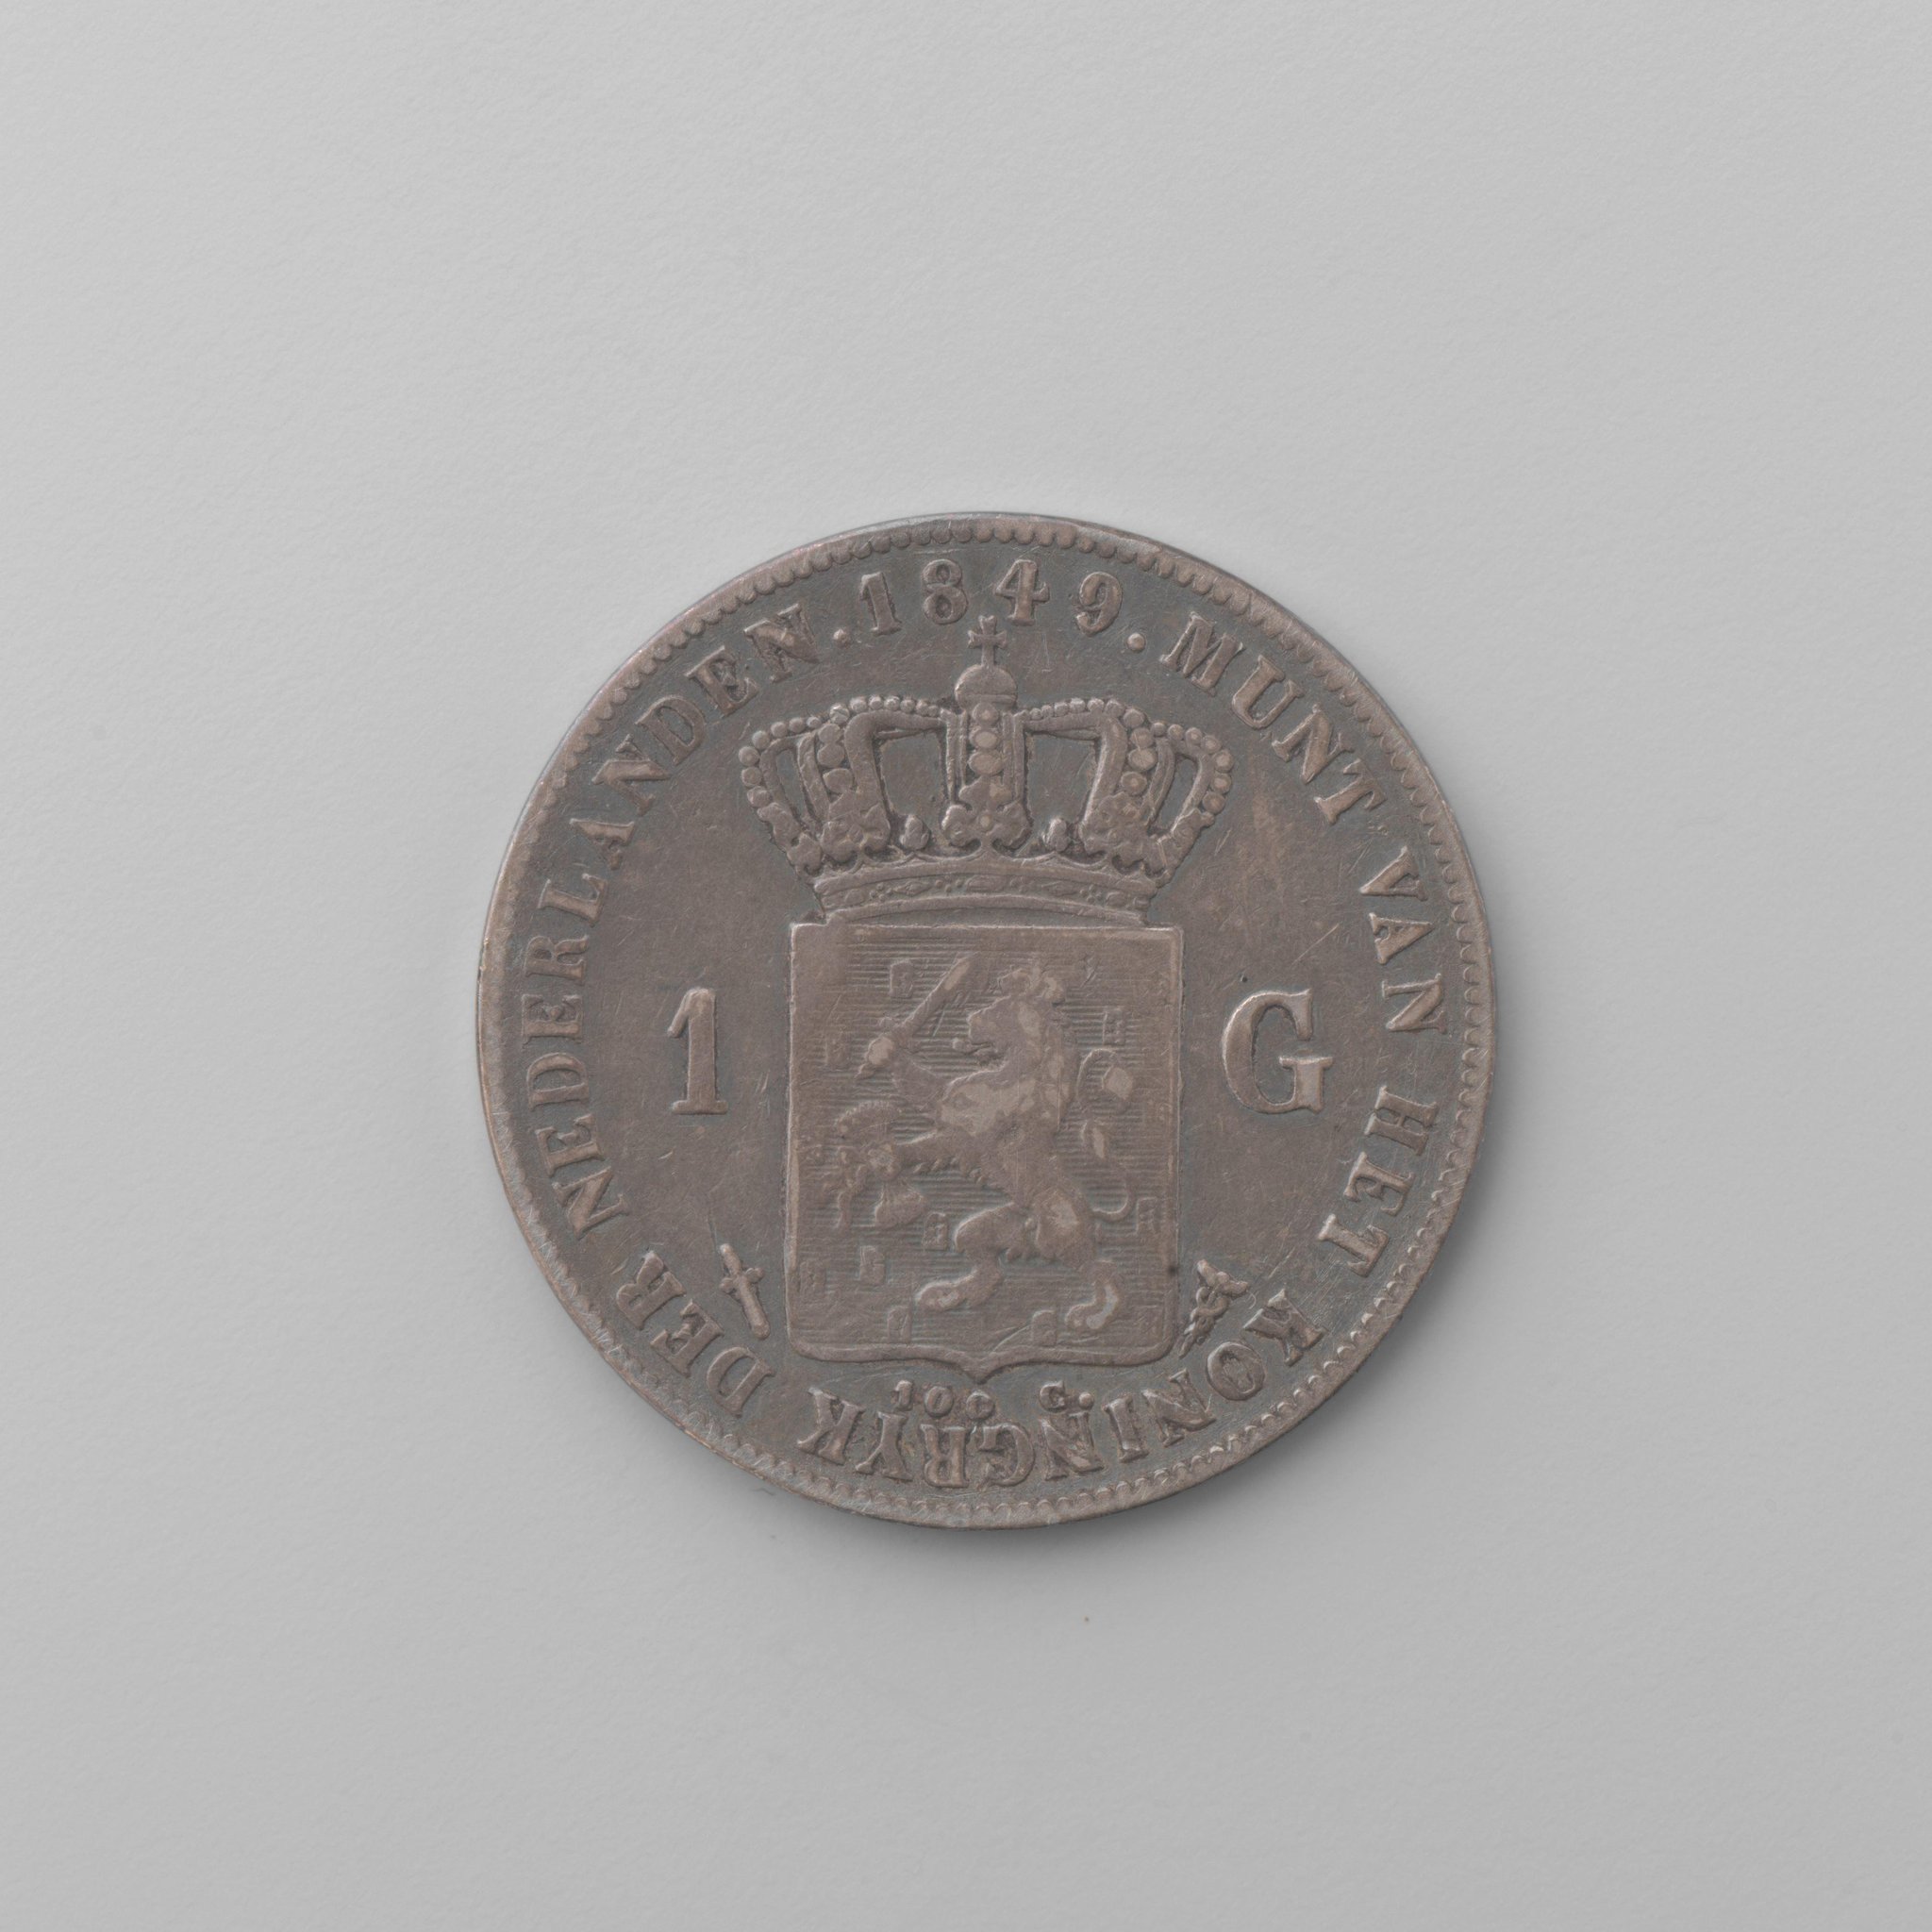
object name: coin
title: Nederland, gulden, 1849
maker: william ii of the netherlands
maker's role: koning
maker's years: 1792-1849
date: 1849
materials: silver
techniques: striking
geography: utrecht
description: Zilveren munt. Voorzijde: borstbeeld naar links. Keerzijde: tussen waarde-aanduiding 1 G gekroond rijkswapenschild. Jaartal boven kroon. Randschrift.